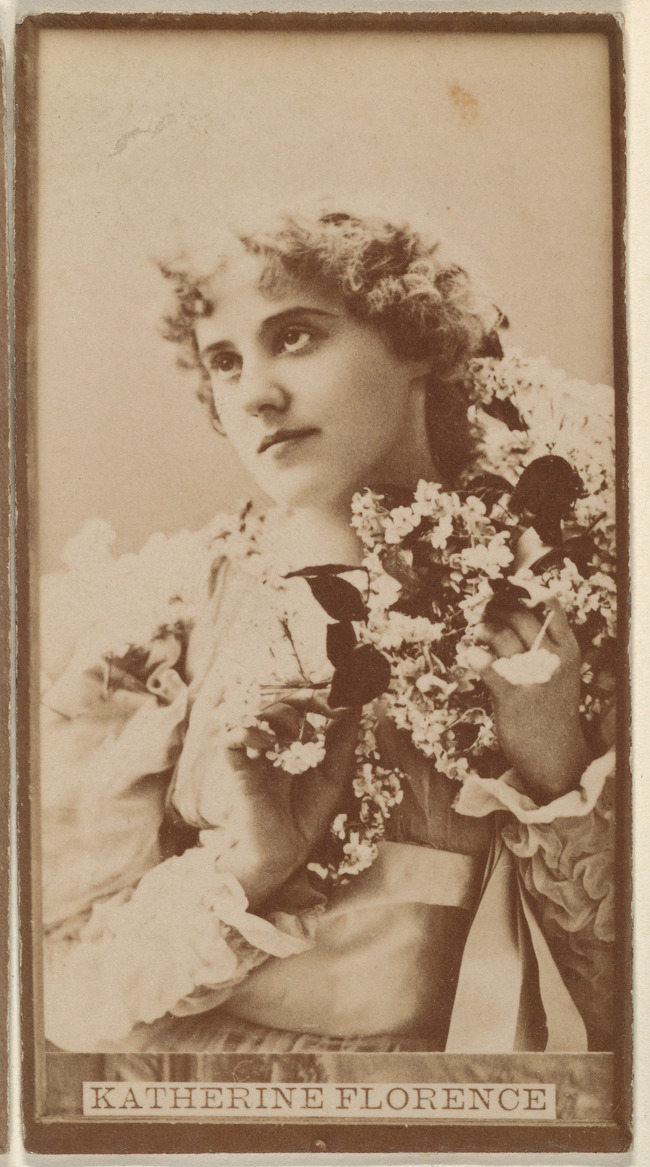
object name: photograph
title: Katherine Florence, from the Actresses series (N668)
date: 1888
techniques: albumen silver print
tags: portraits,women,flowers,actresses